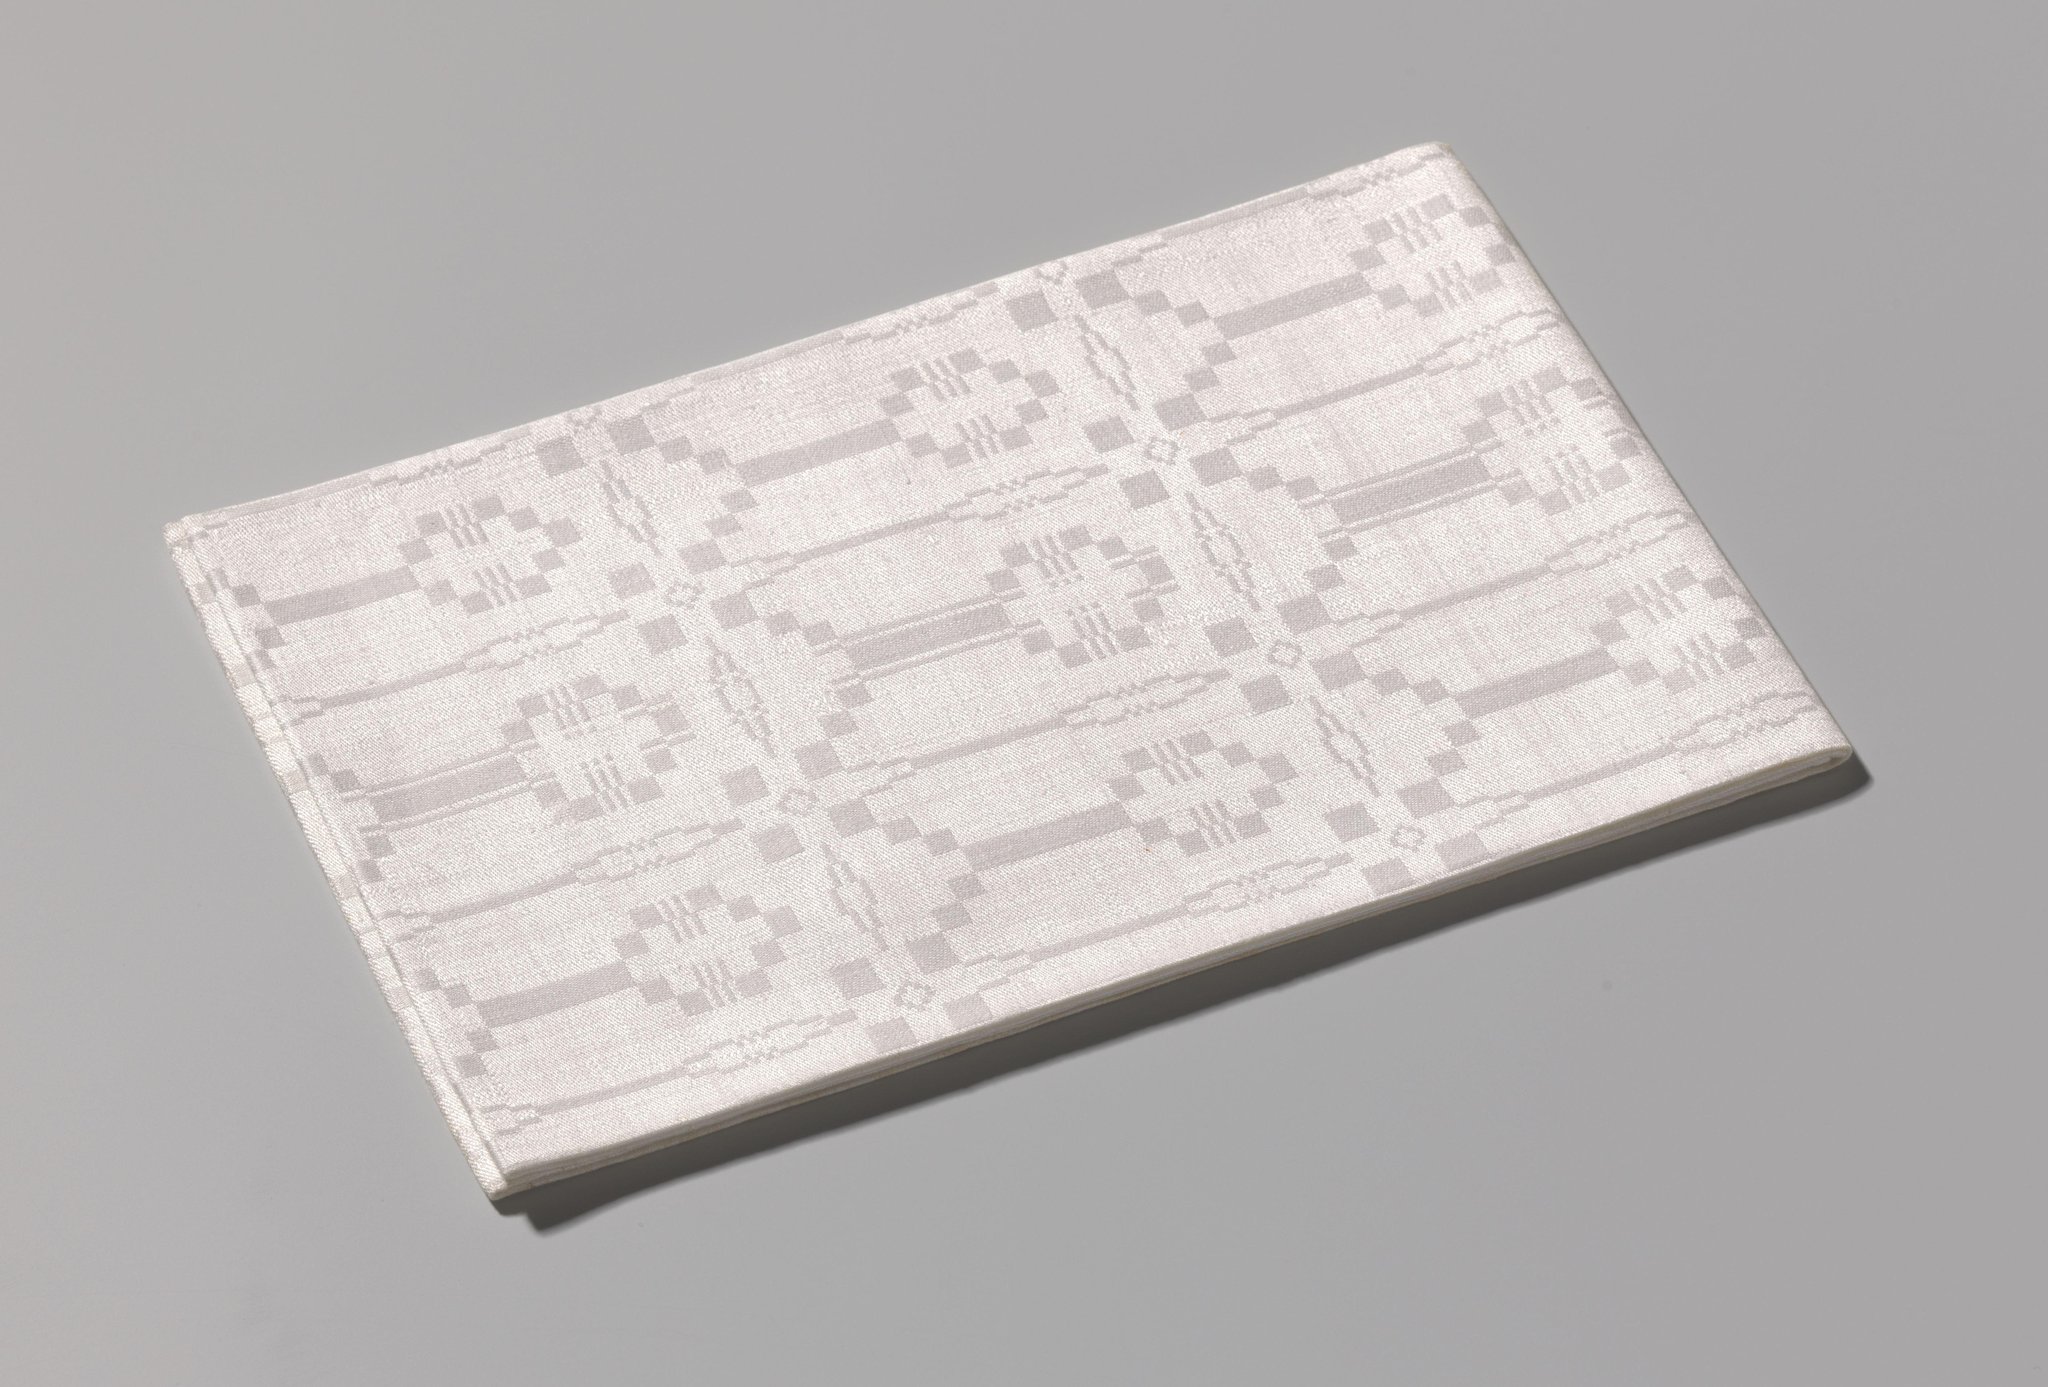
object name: napkin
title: Servet van linnen met pellenpatroon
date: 1726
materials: linen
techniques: peeled fabric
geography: northern netherlands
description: wit linnen servet met pellen patroon, merk GS 60 en 1726